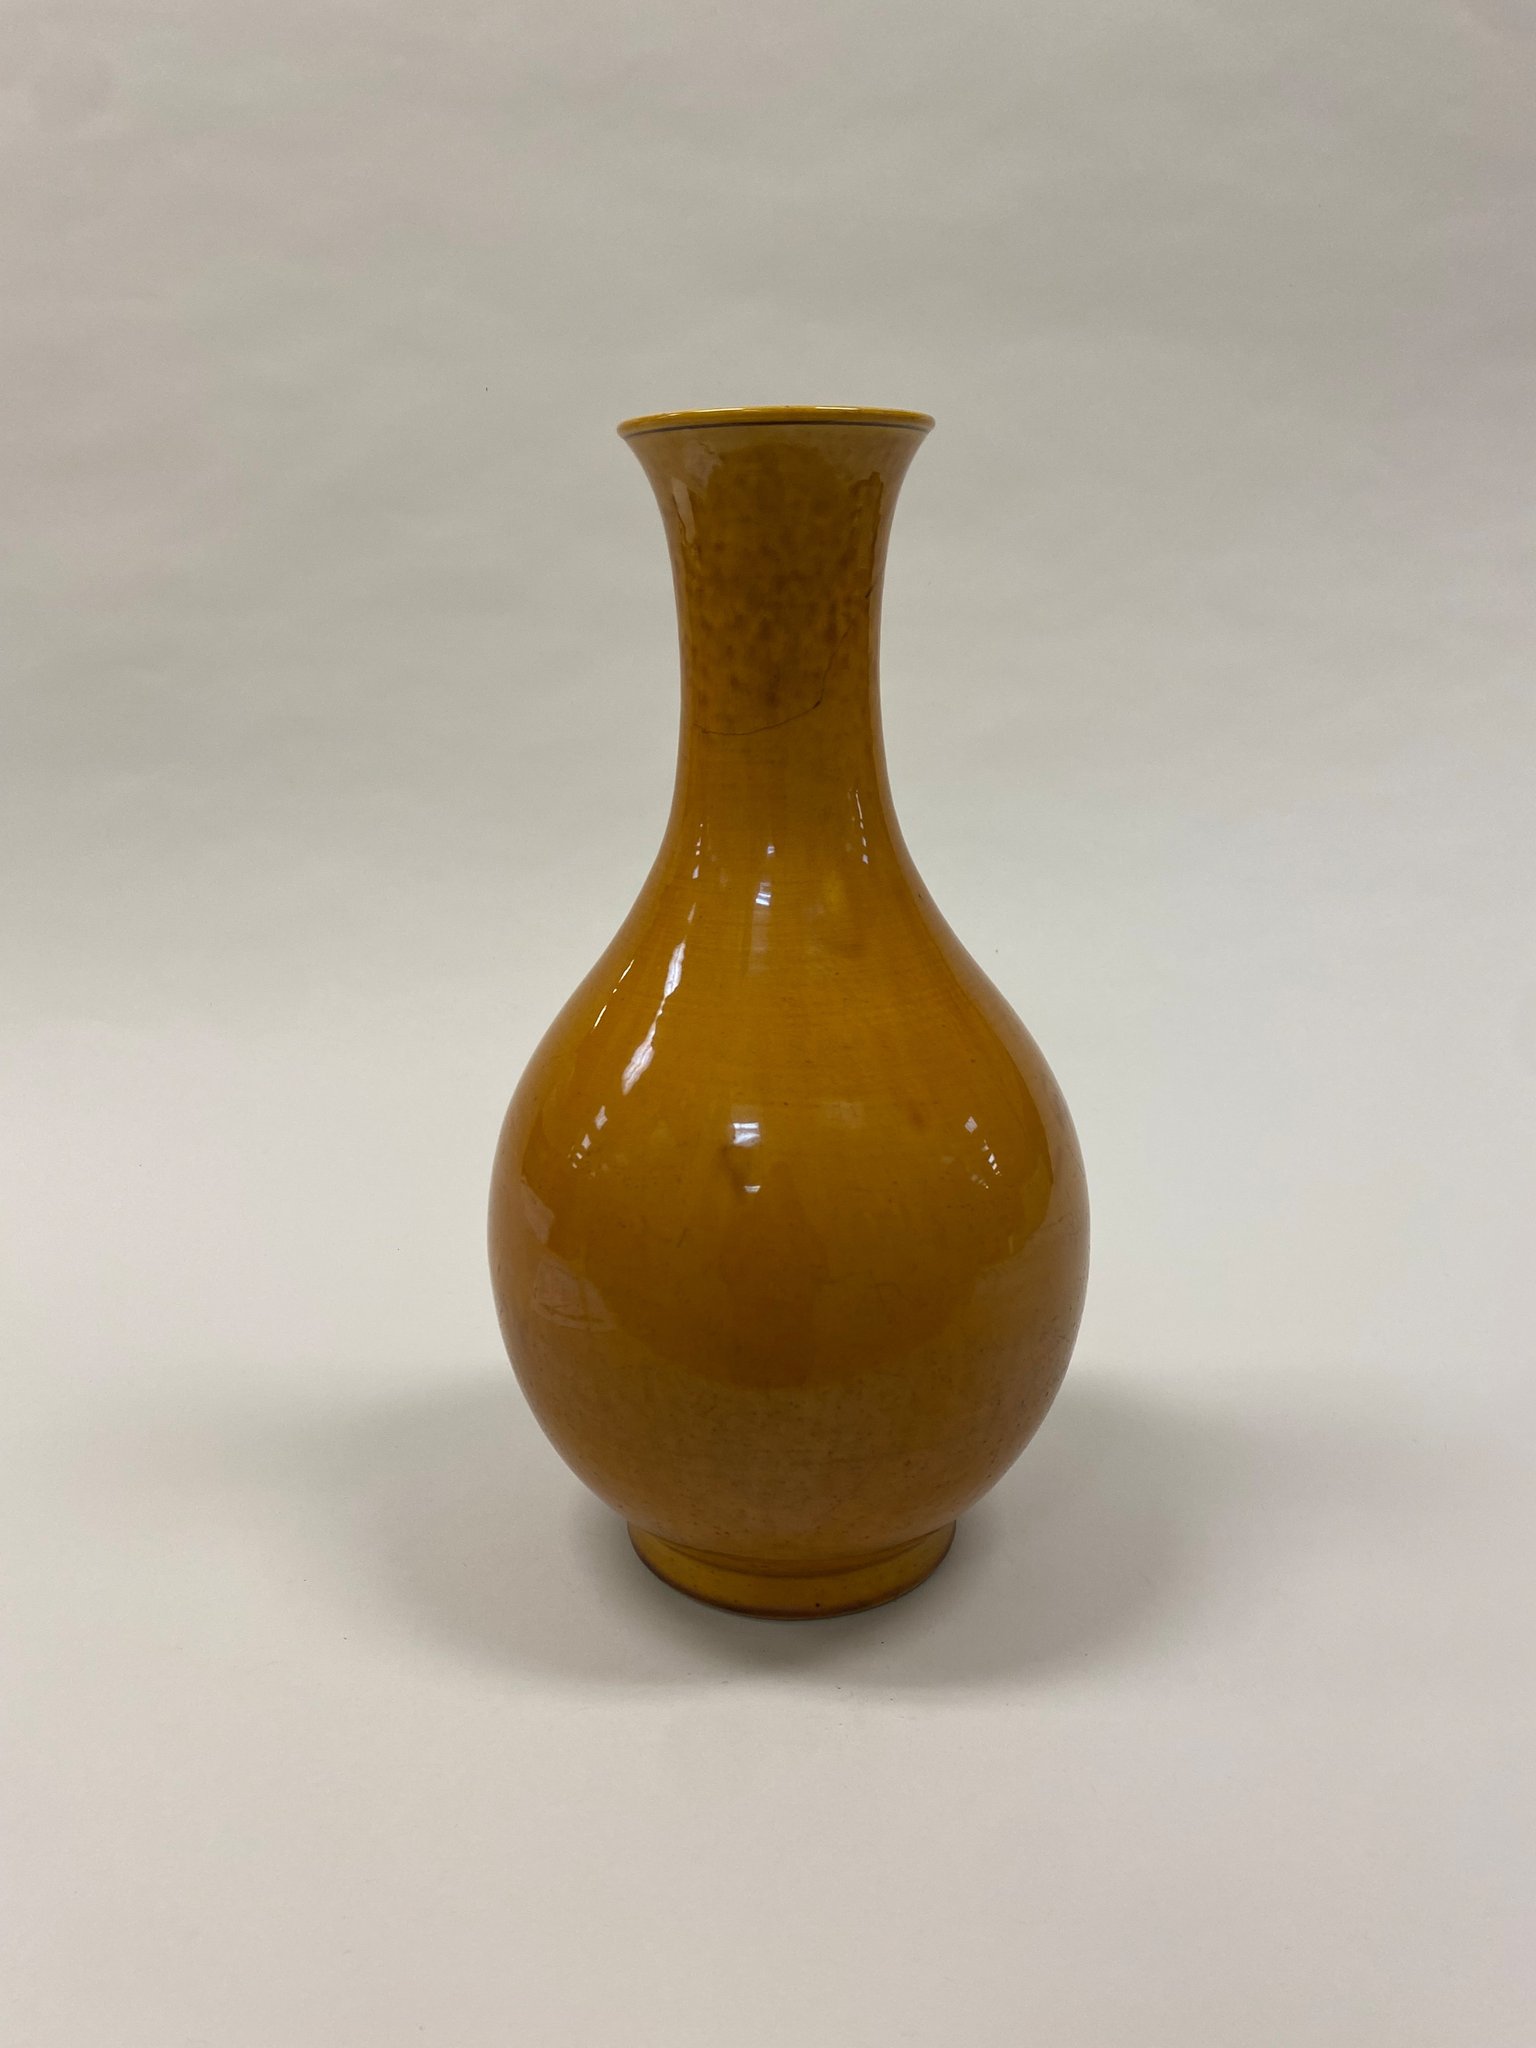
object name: vase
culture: chinese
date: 1701-1800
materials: glaze